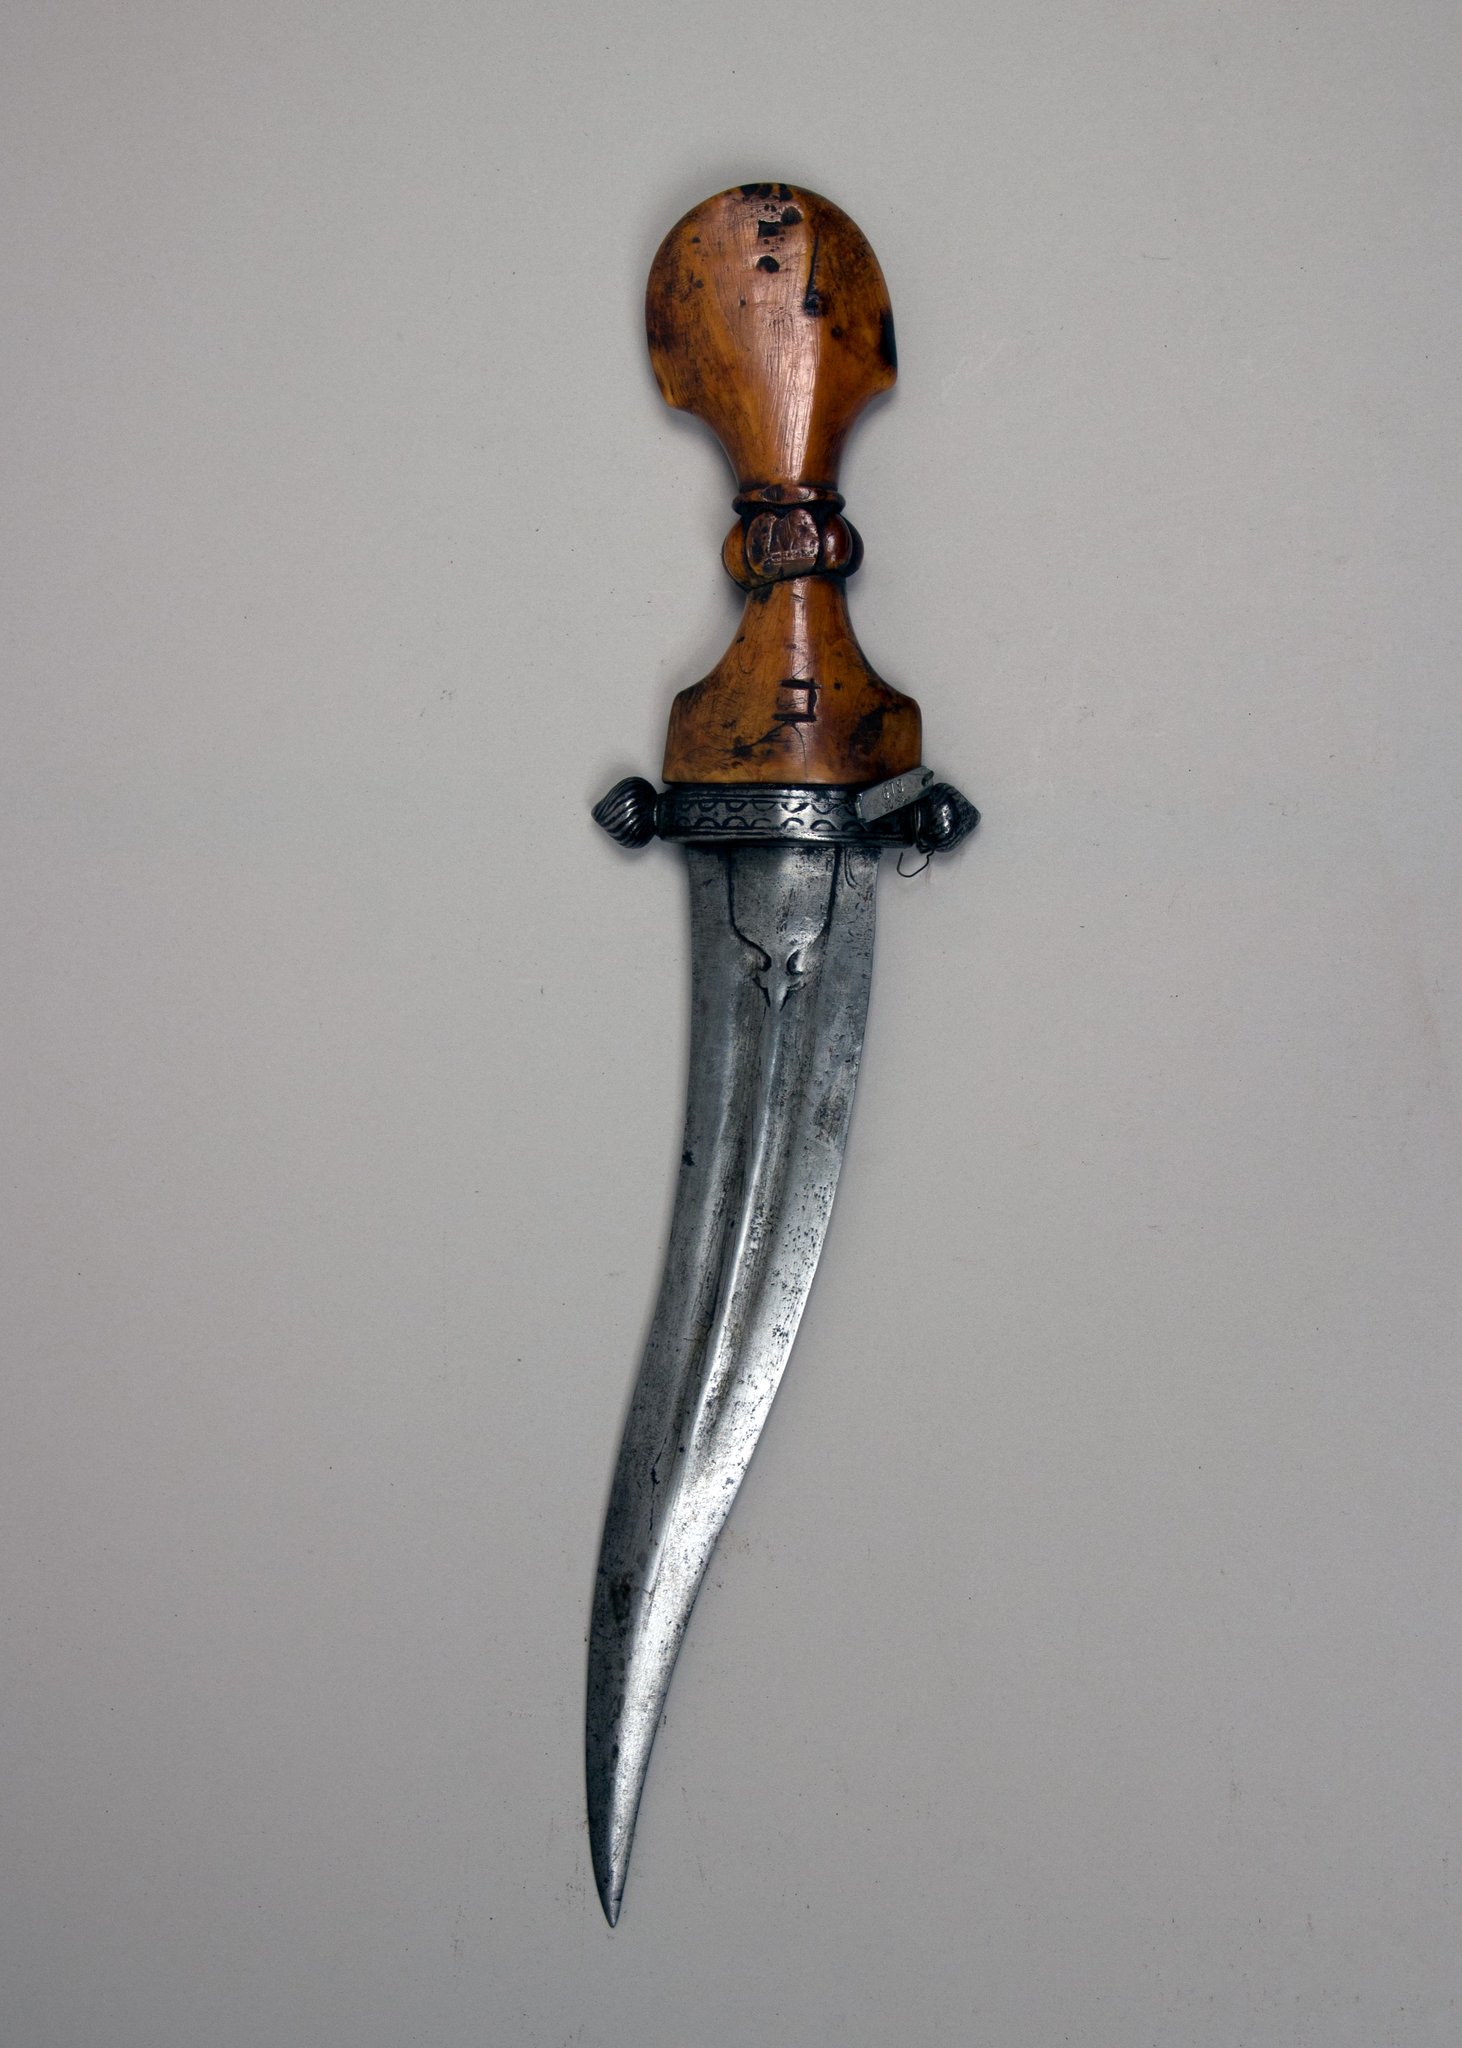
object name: dagger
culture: indian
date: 1801-1900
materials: iron, ivory, steel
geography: india